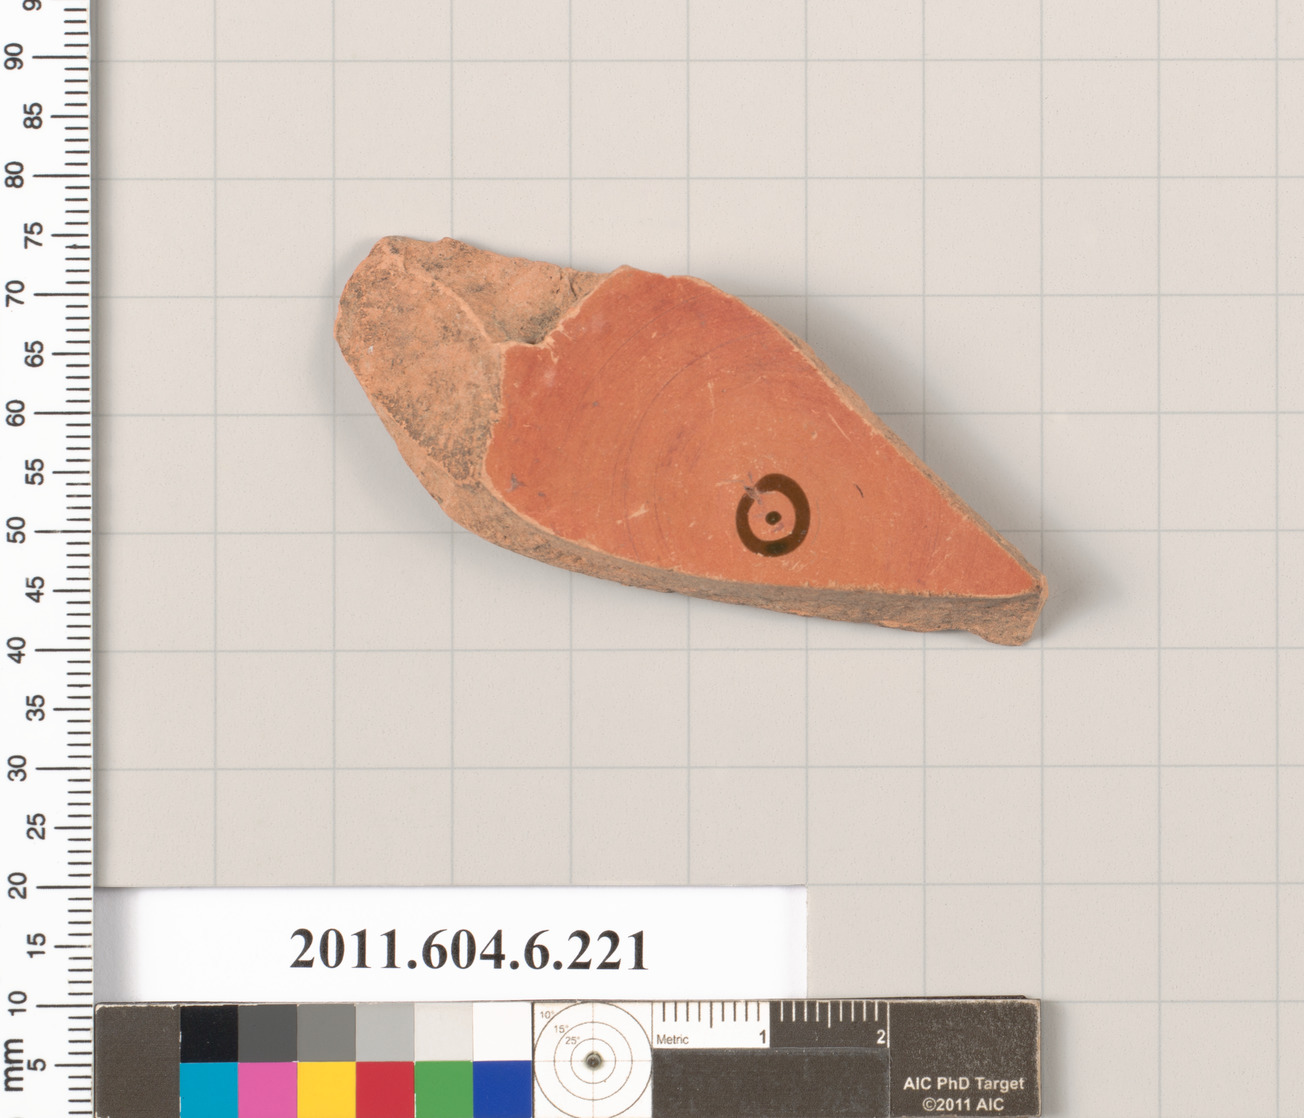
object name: undetermined open shape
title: Terracotta fragment of an open shape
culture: greek, attic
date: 600-401 BCE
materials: terracotta